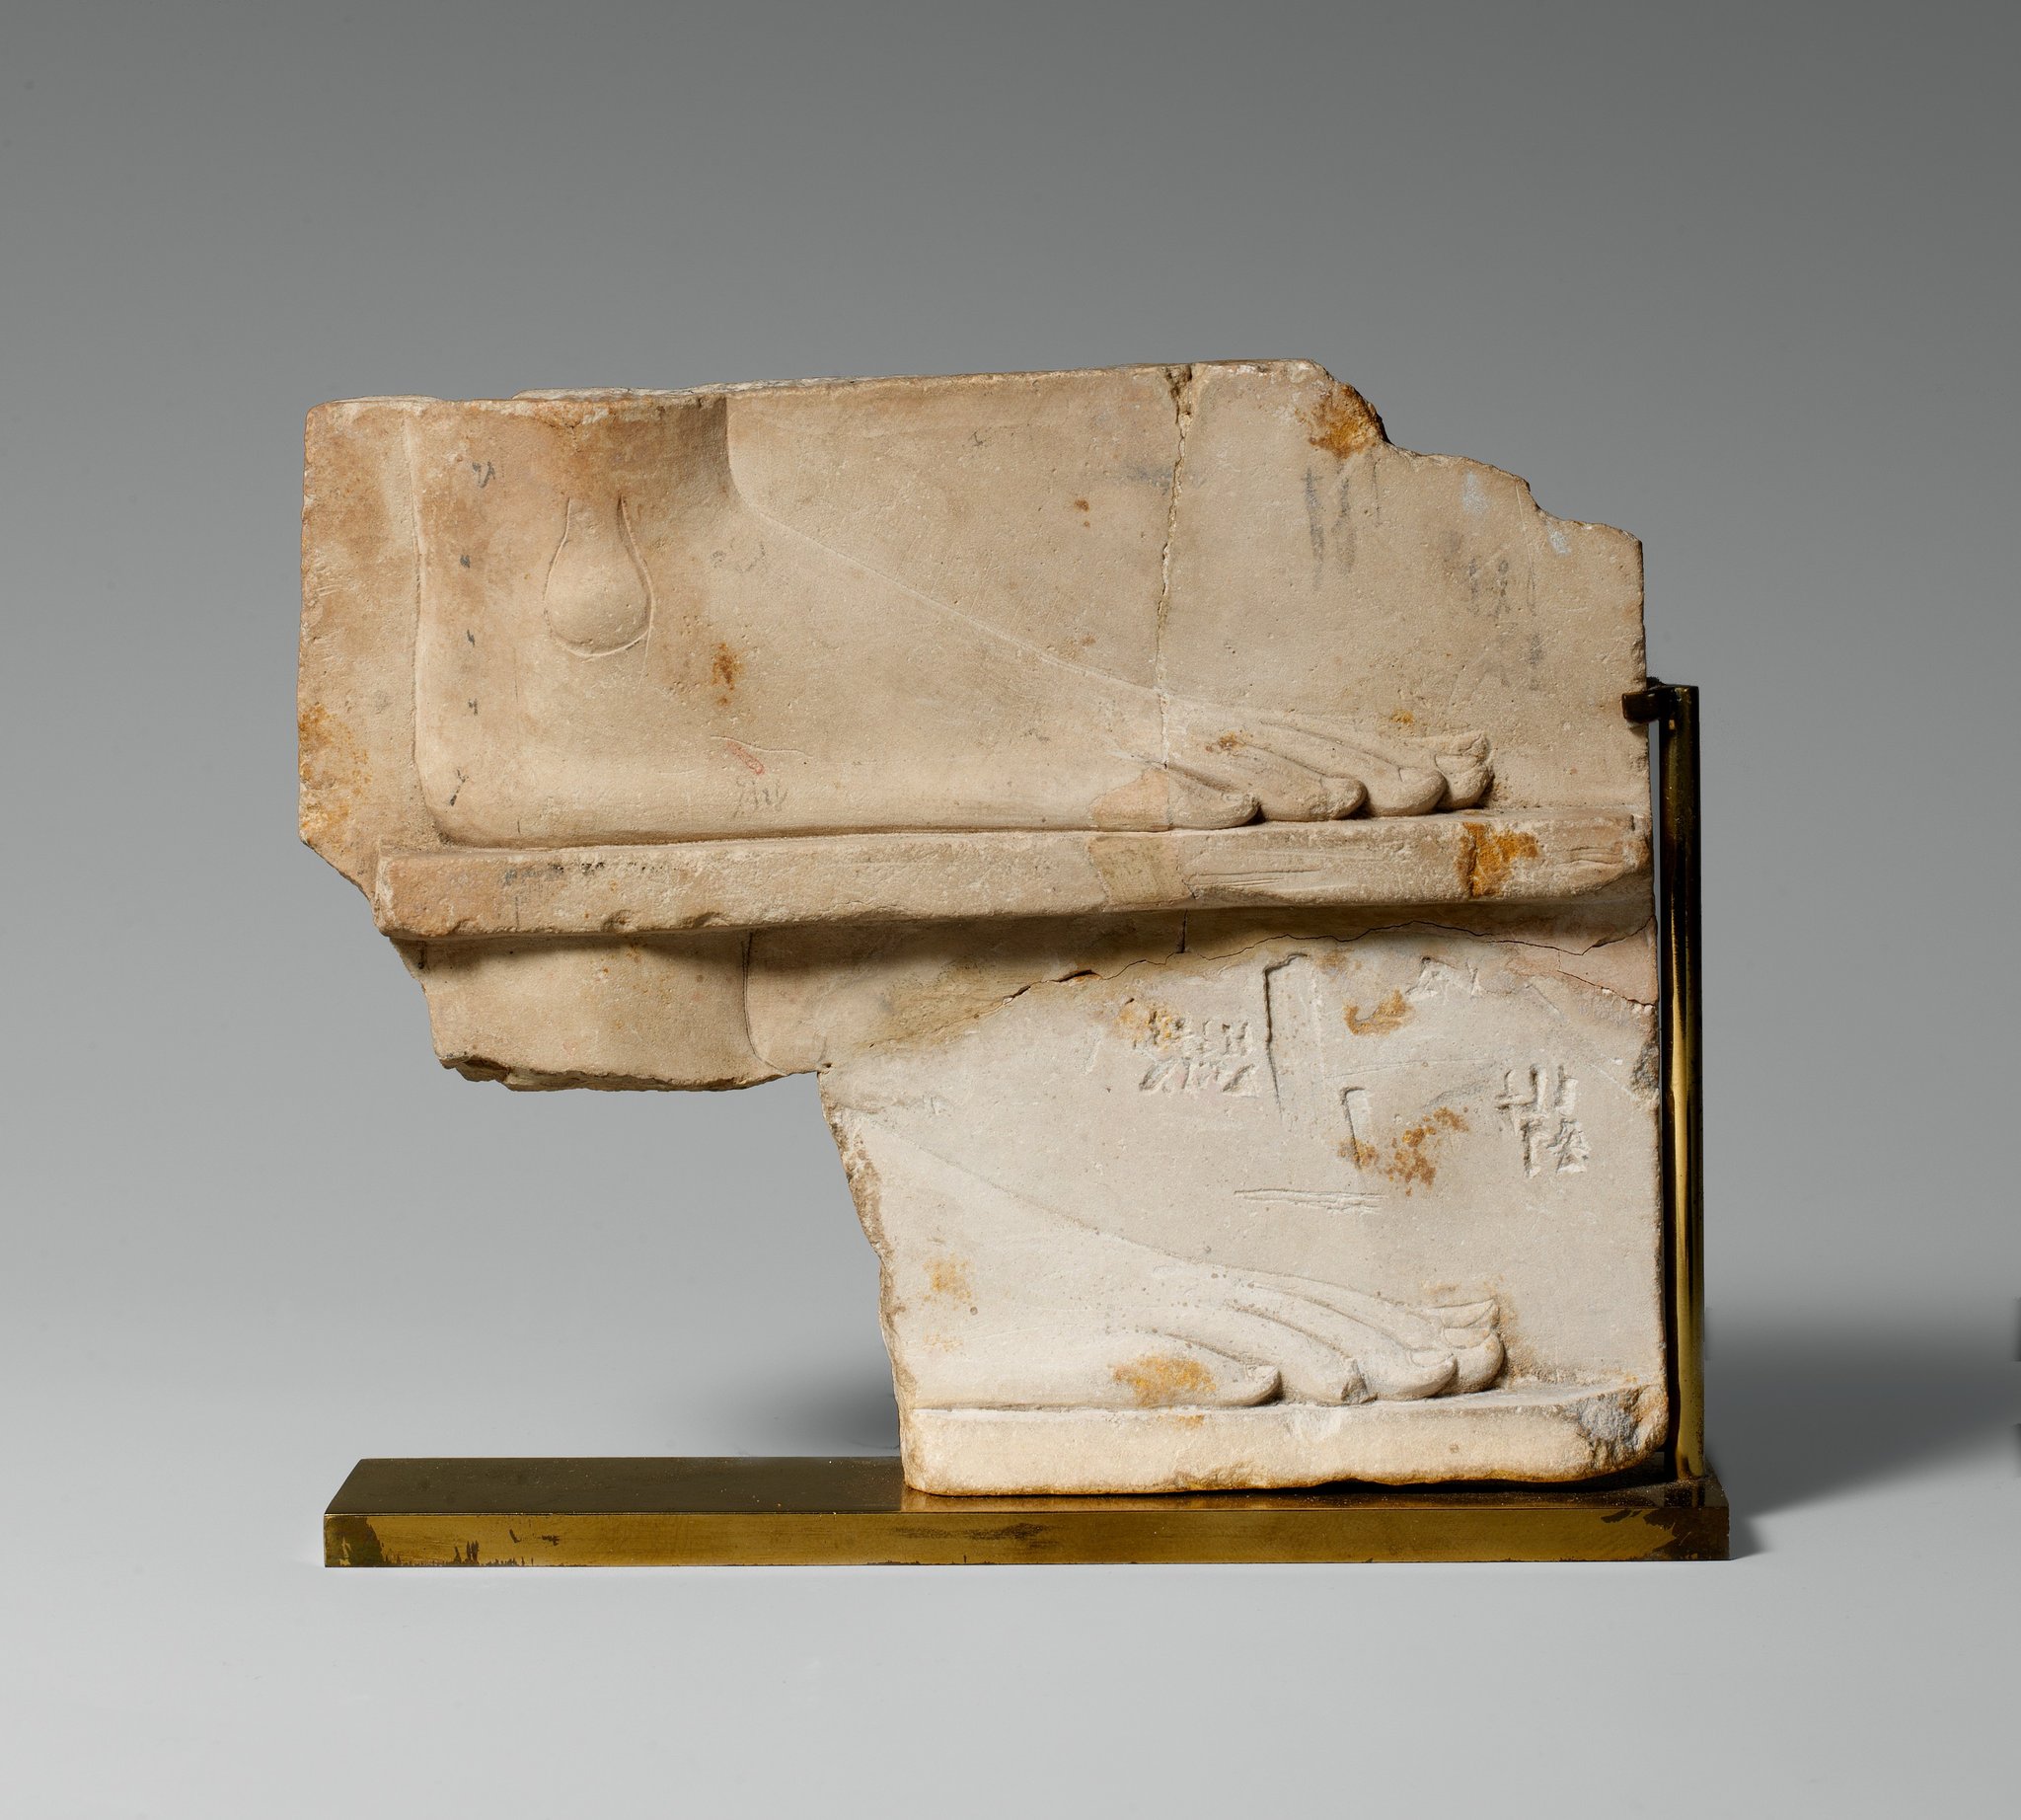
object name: sculptor's model votive, foot, royal like figure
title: Sculptor's model / votive relief with two sides: side one, two registers with a right foot on each; side two, a royal-like figure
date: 400-200 BCE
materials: limestone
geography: egypt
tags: feet